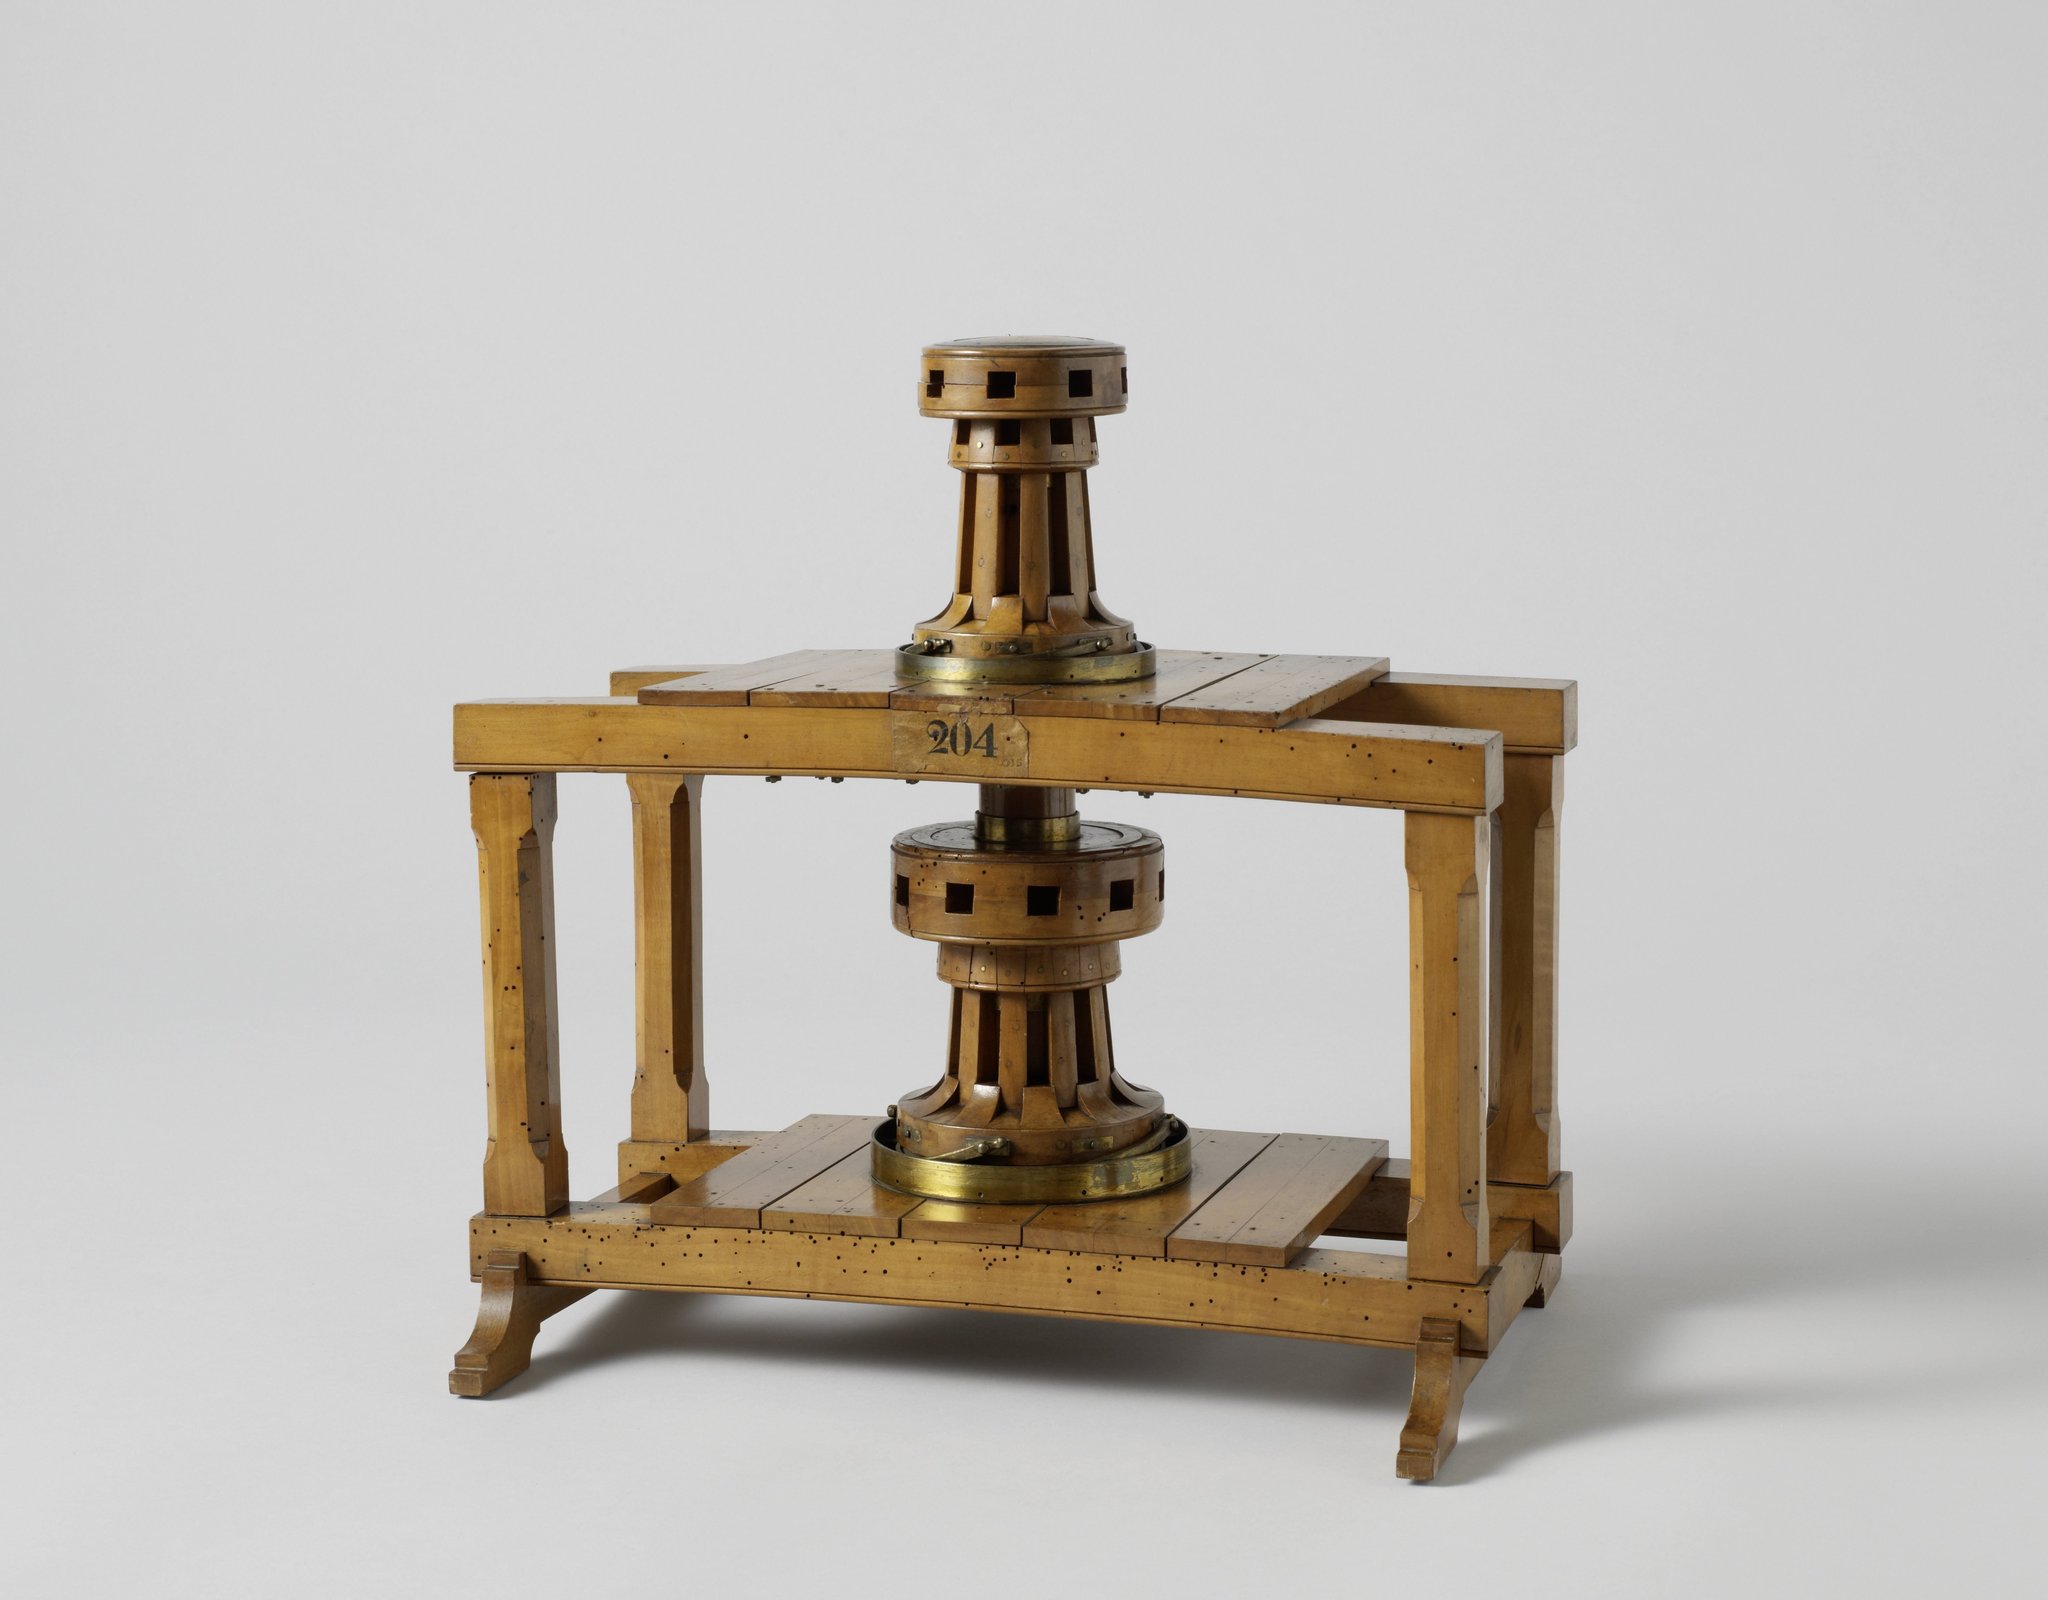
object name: demonstration model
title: Model of a Double Capstan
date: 1821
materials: brass, iron, wood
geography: flushing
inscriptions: label, on the frame: ‘204’ former inventory label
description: Model van een dubbele kaapstander in een houten frame dat twee dekken voorstelt. De bovenste kaapstander is voor acht windbomen, de onderste voor tien. Beide hebben vier pallen in de voet tegen het teruglopen. De bovenste kaapstander heeft een holle houten koning, waarbinnen de verlengde metalen koning van de onderste kaapstander loopt; met twee ijzeren spieën door de bovenste trommel worden de twee koningen aan elkaar verbonden, zodat de twee kaapstanders één worden. Als de spieën verwijderd zijn, heeft men twee onafhankelijke kaapstanders. Schaal 1:10 (schatting). Identiek aan NG-MC-204-A.